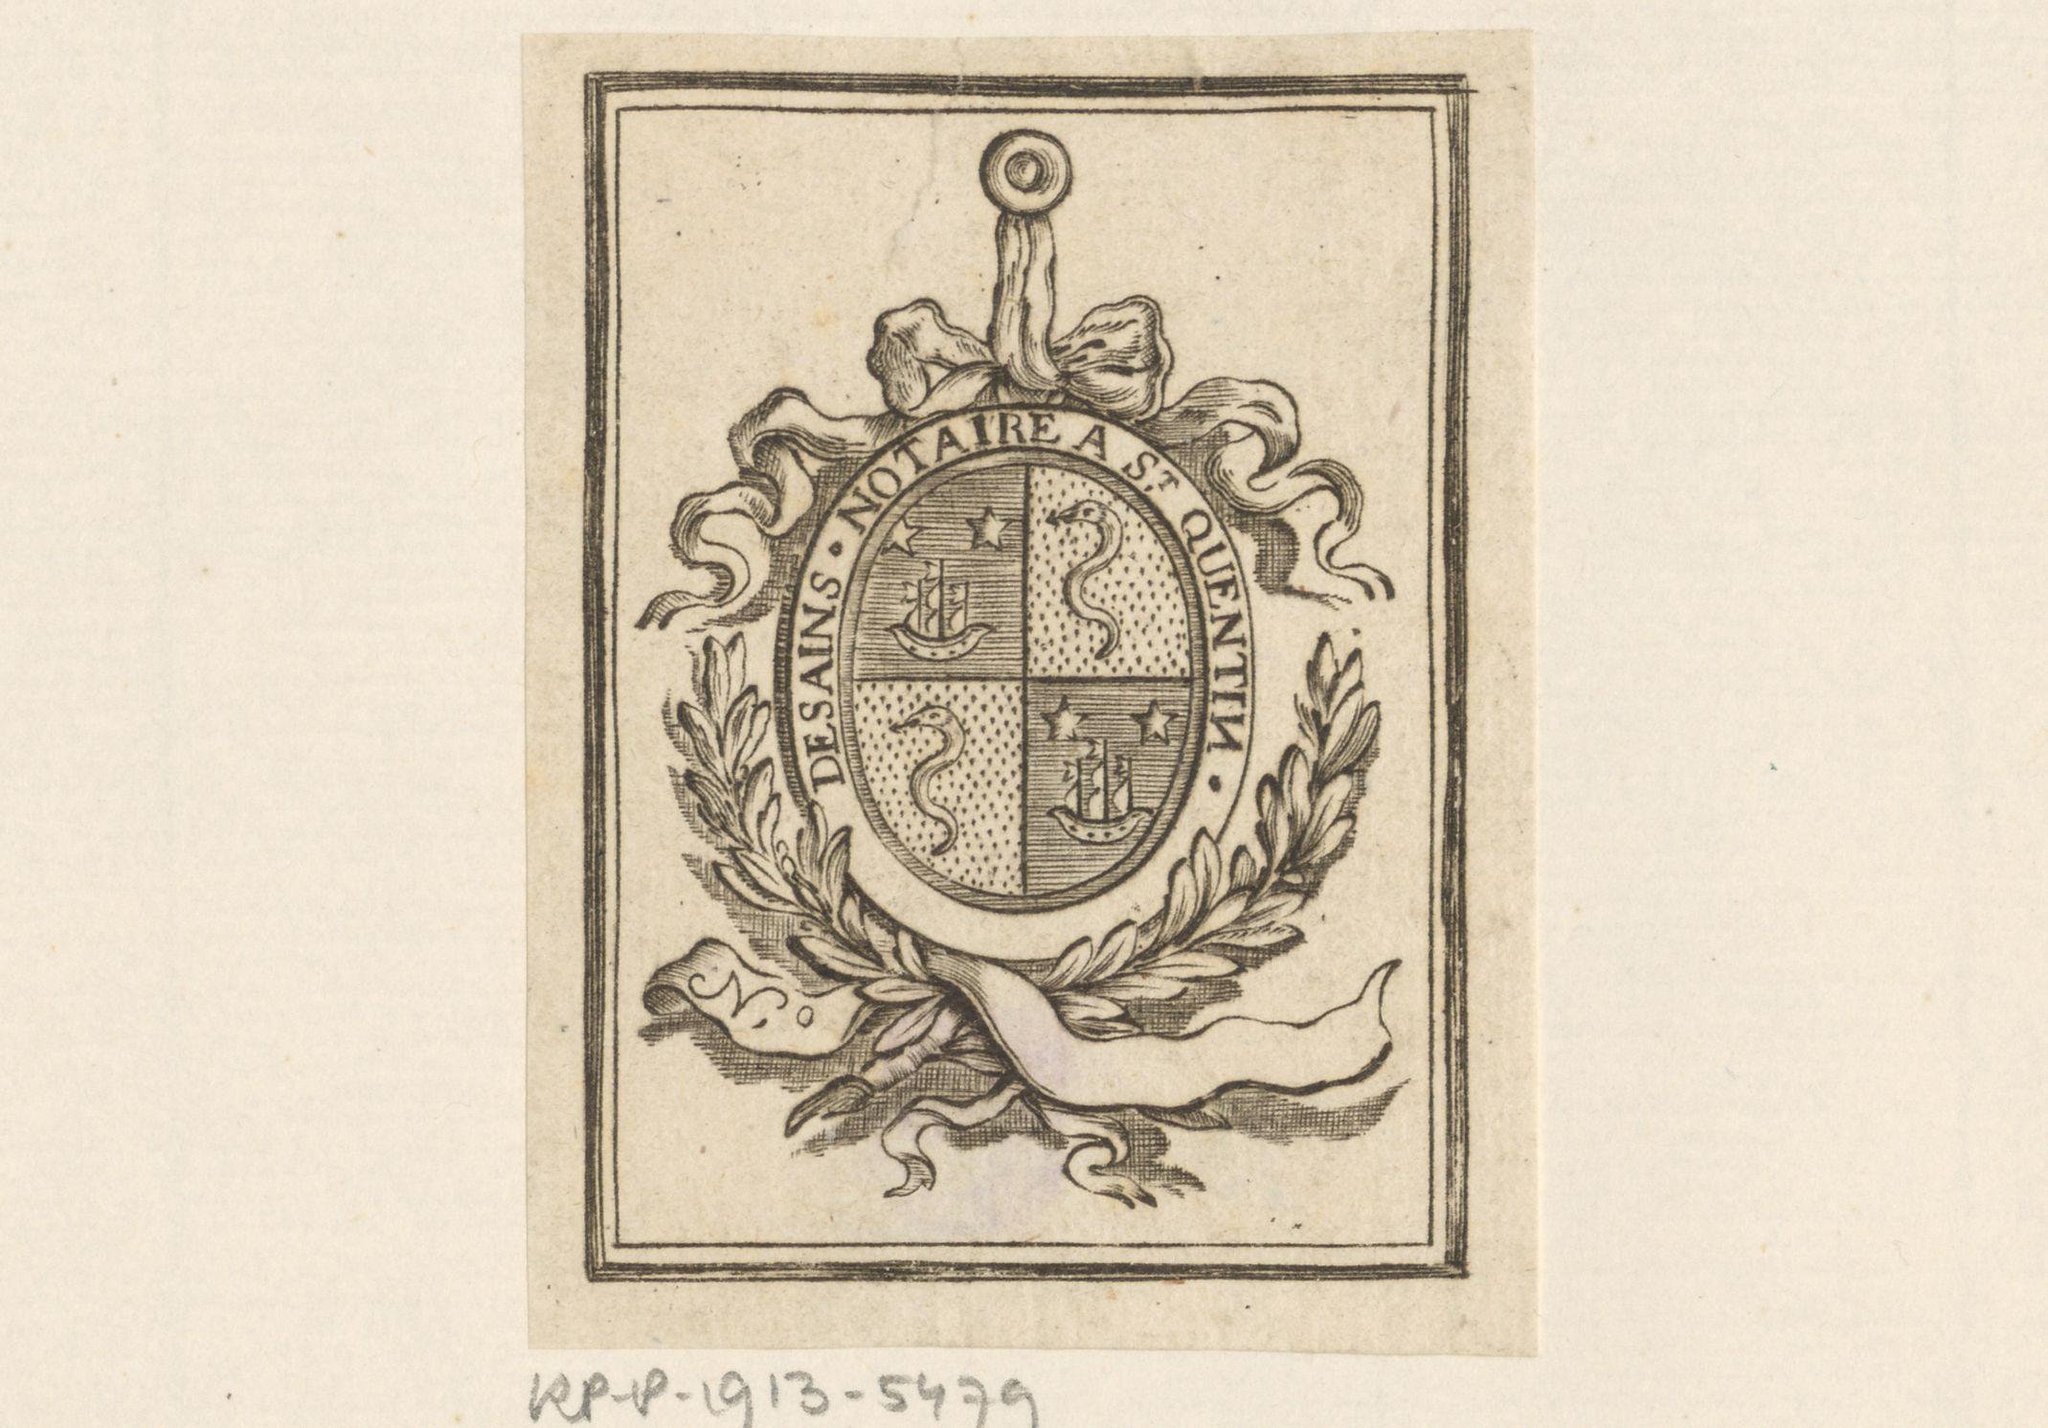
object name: bookplate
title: Desains notaire a St. Quentin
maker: Anonymous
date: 1700-1849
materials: paper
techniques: etching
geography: france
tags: snakes, sailing-ship, sailing-boat, garland, wreath, armorial bearing, heraldry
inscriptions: collector's mark: Lugt 2760, collector's mark: Lugt 2233